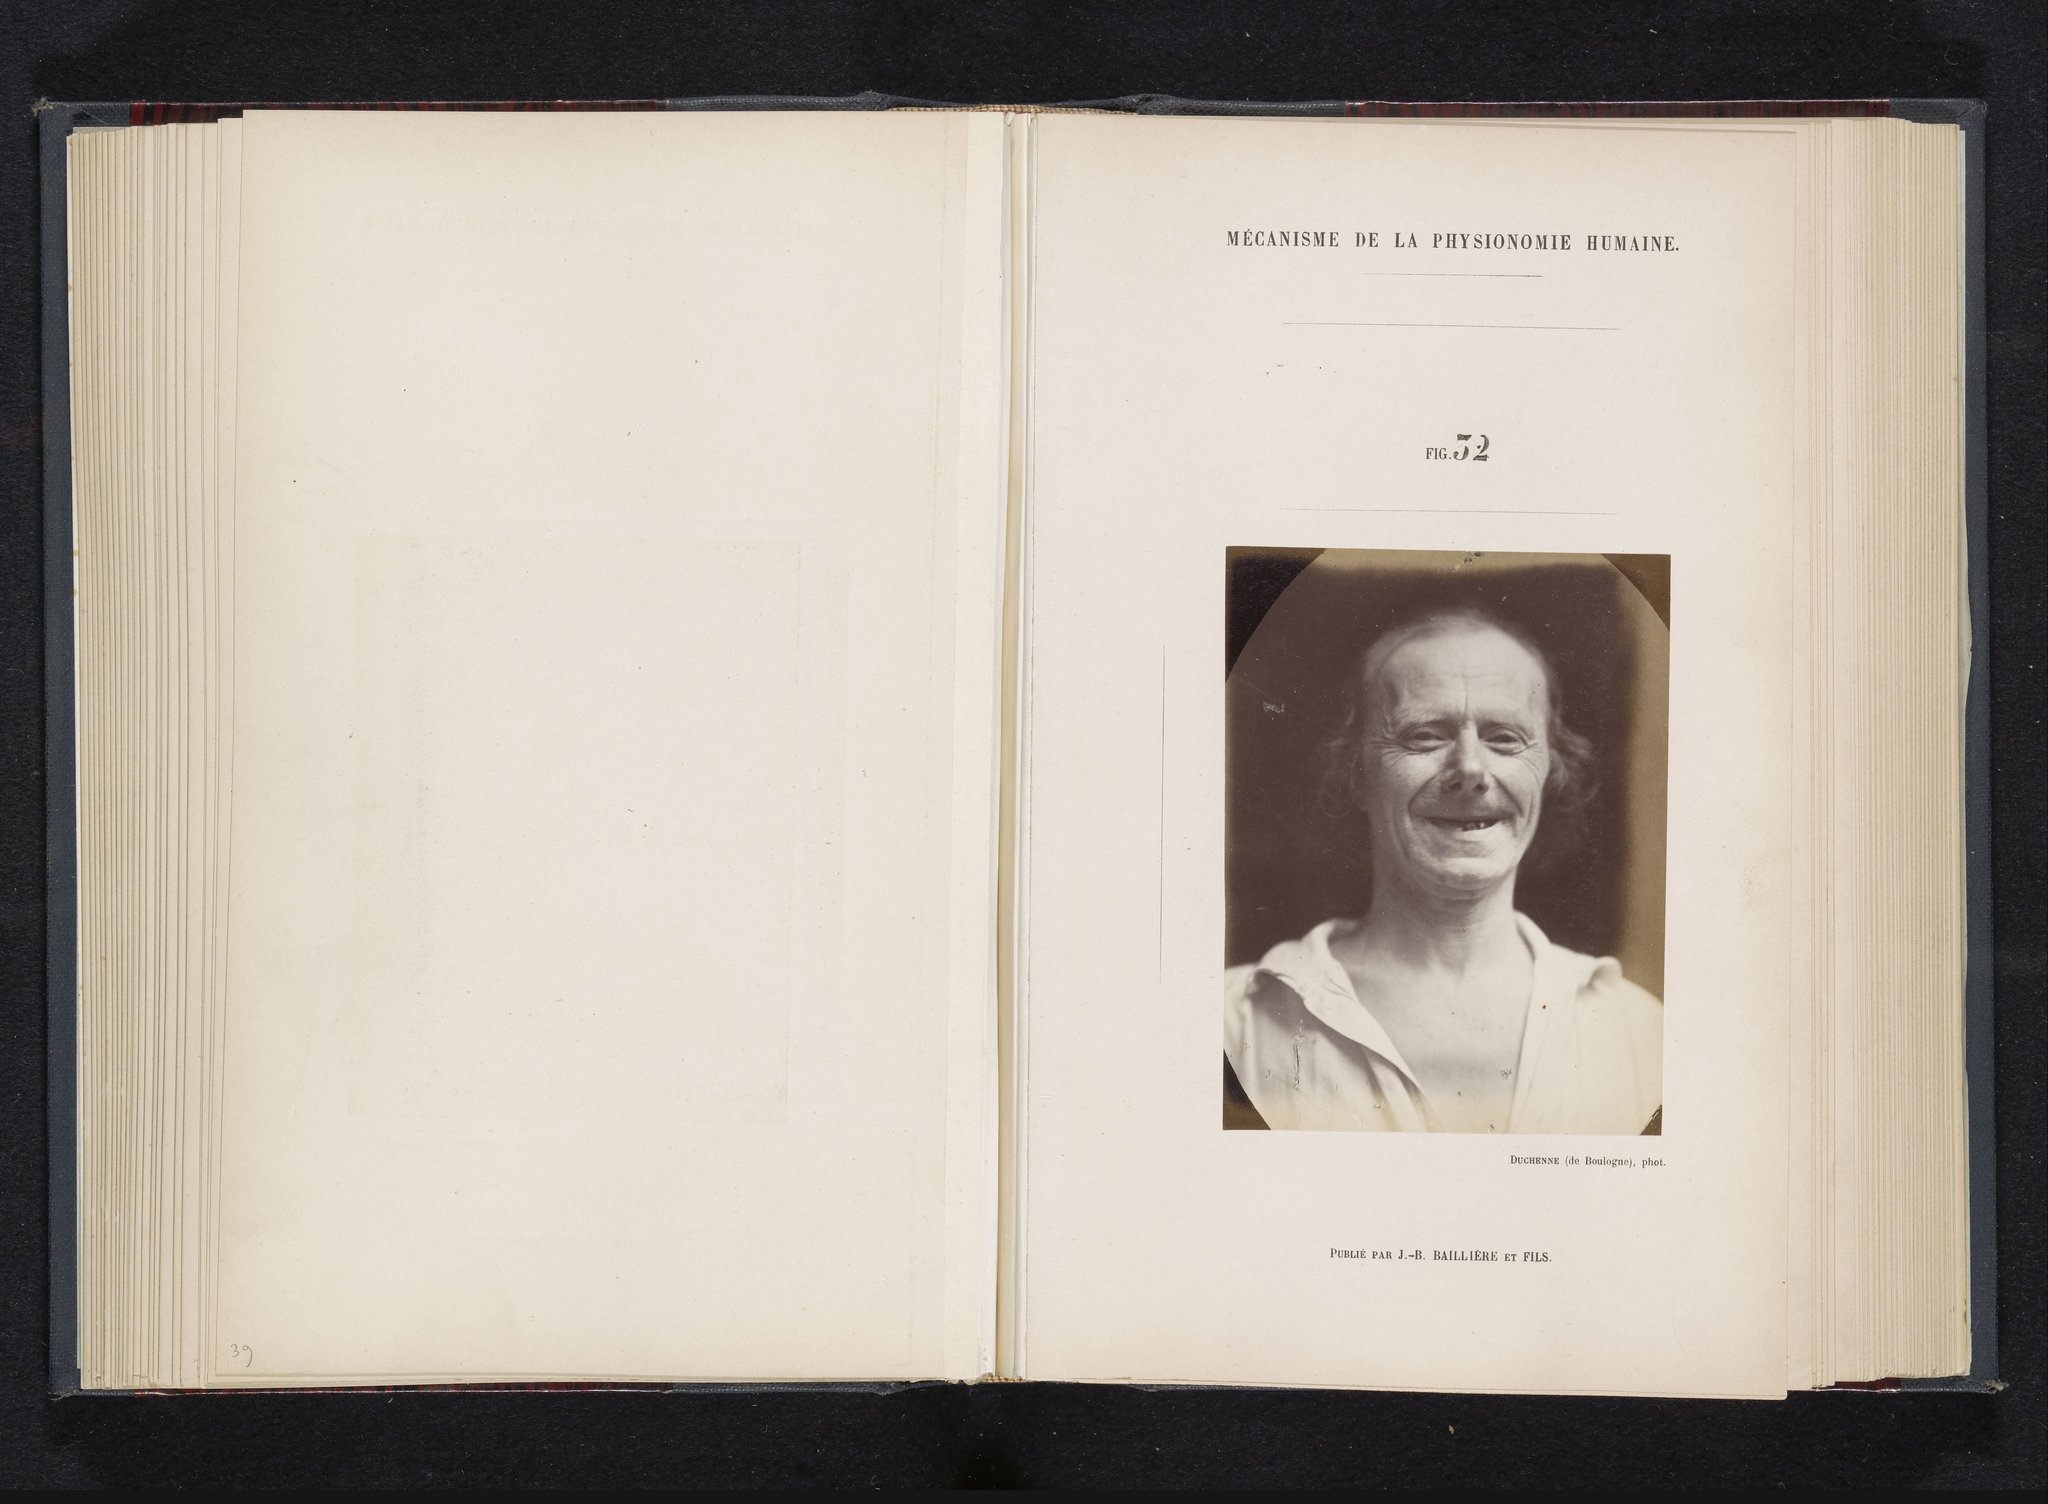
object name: photograph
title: Portret van een proefpersoon: 'un vieillard'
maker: guillaume benjamin amand duchenne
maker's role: fotograaf, medicus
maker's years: 1806-1875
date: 1860-1862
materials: paper, photographic support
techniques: albumen print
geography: paris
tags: face, physiology and anatomy ~ nervous system, neurology, physiology and anatomy, old man, morphology of facial expression, physiognomy, experiment, test ~ science and technology, france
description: Ongenummerde pagina met foto 32 uit Mécanisme de la physionomie humaine ou analyse électro-physiologique de l'expression des passions (Atlas).